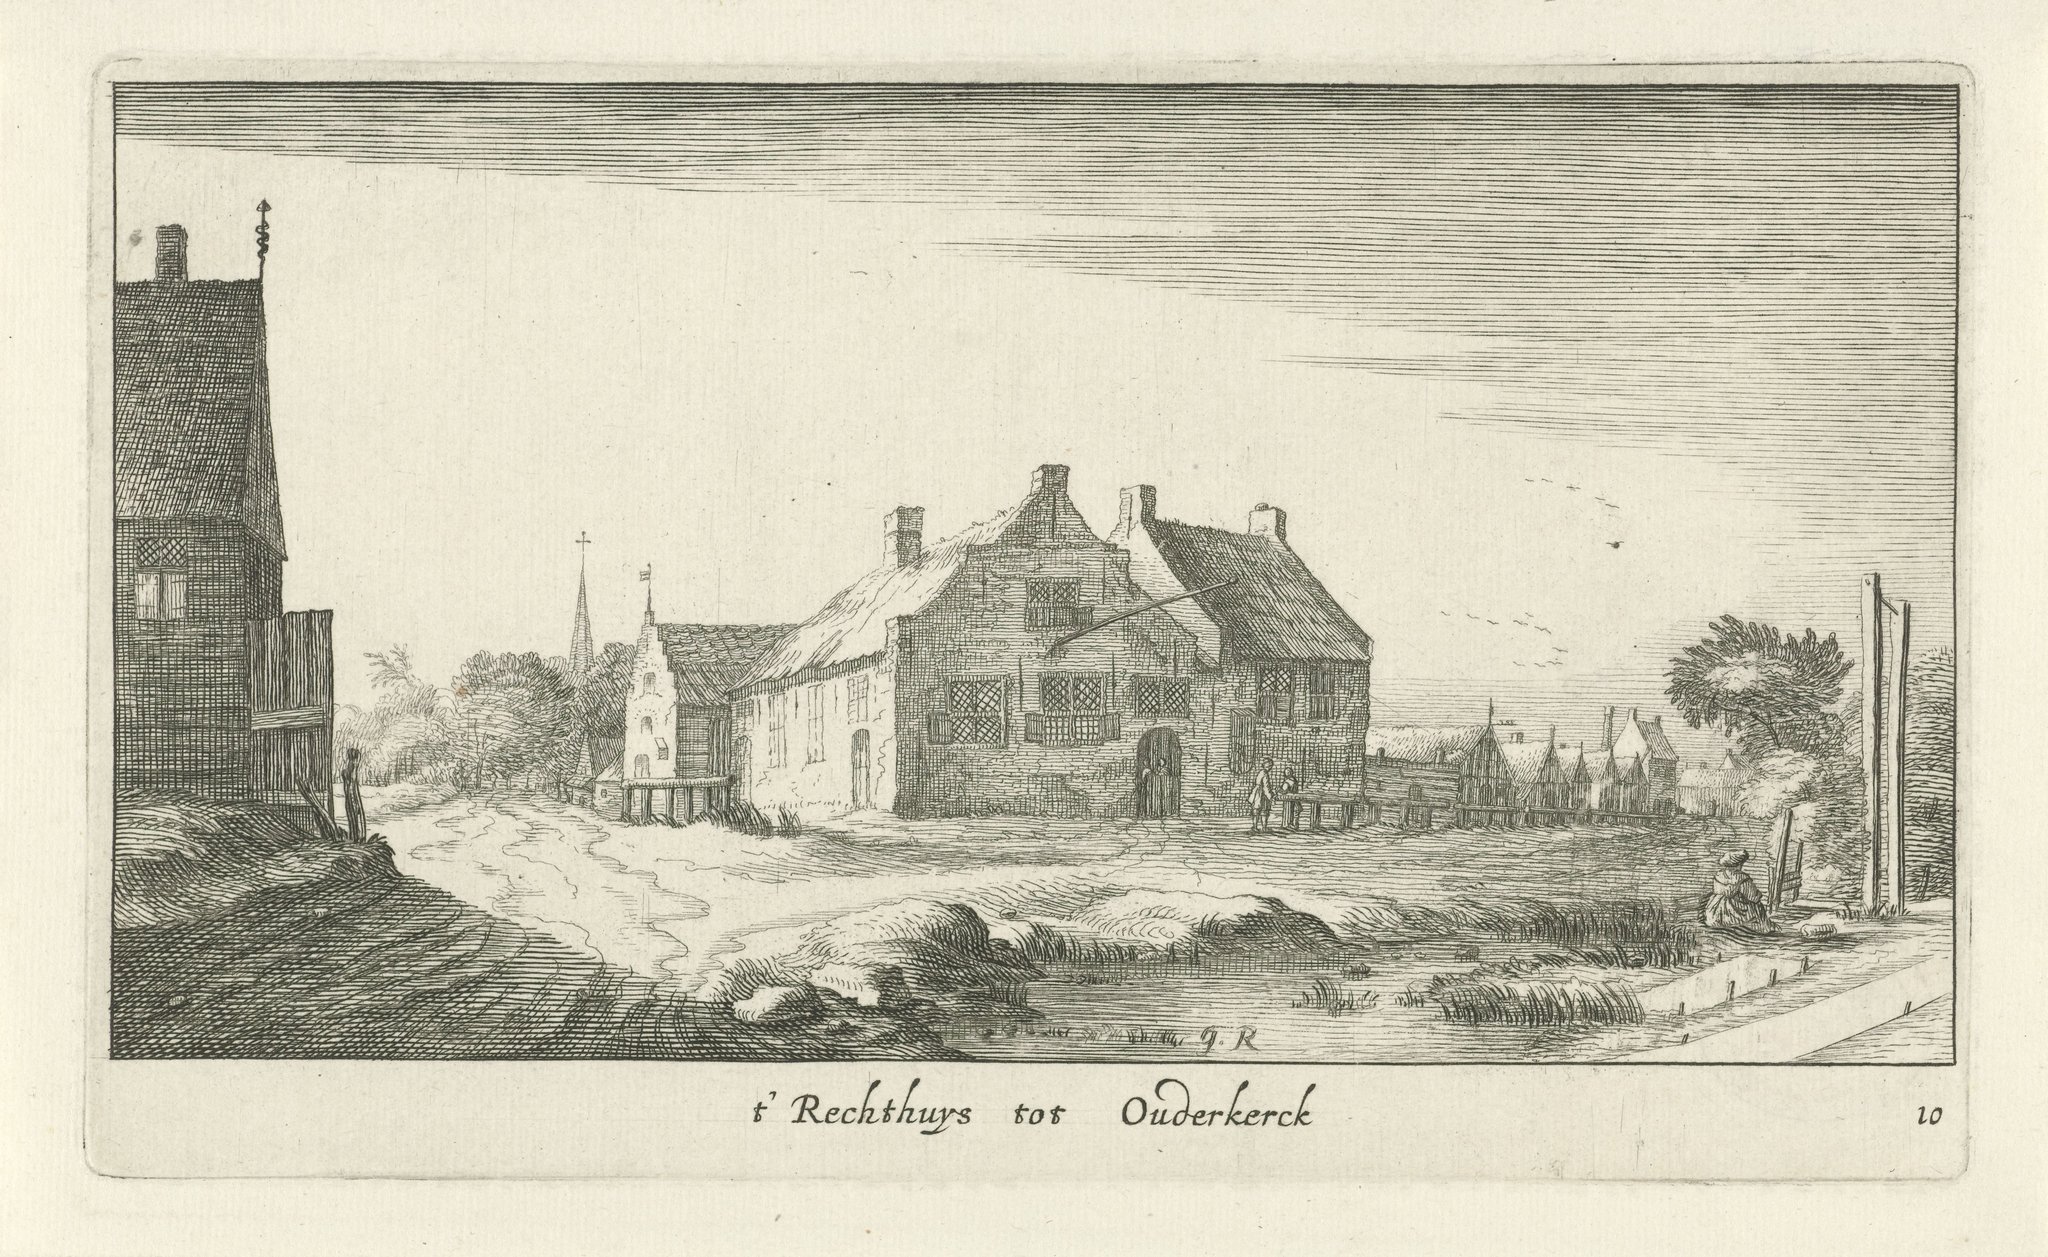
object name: print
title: Plaisante Lantschappen ofte vermakelijcke Gesichten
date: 1637-1652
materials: paper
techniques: engraving, etching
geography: amsterdam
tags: violent death by hanging, lower house, parliament, chamber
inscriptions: collector's mark: Lugt 240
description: Gezicht op het Rechthuis te Ouderkerk aan de Amstel, gelegen op de hoek van de Dorpsstraat (rechts) en het Kerkpad (links). Rechts van de Dorpsstraat het gerecht met de galg. De prent is deel van een serie landschappen met dorpen rondom Amsterdam. Rechtsonder genummerd: 10.